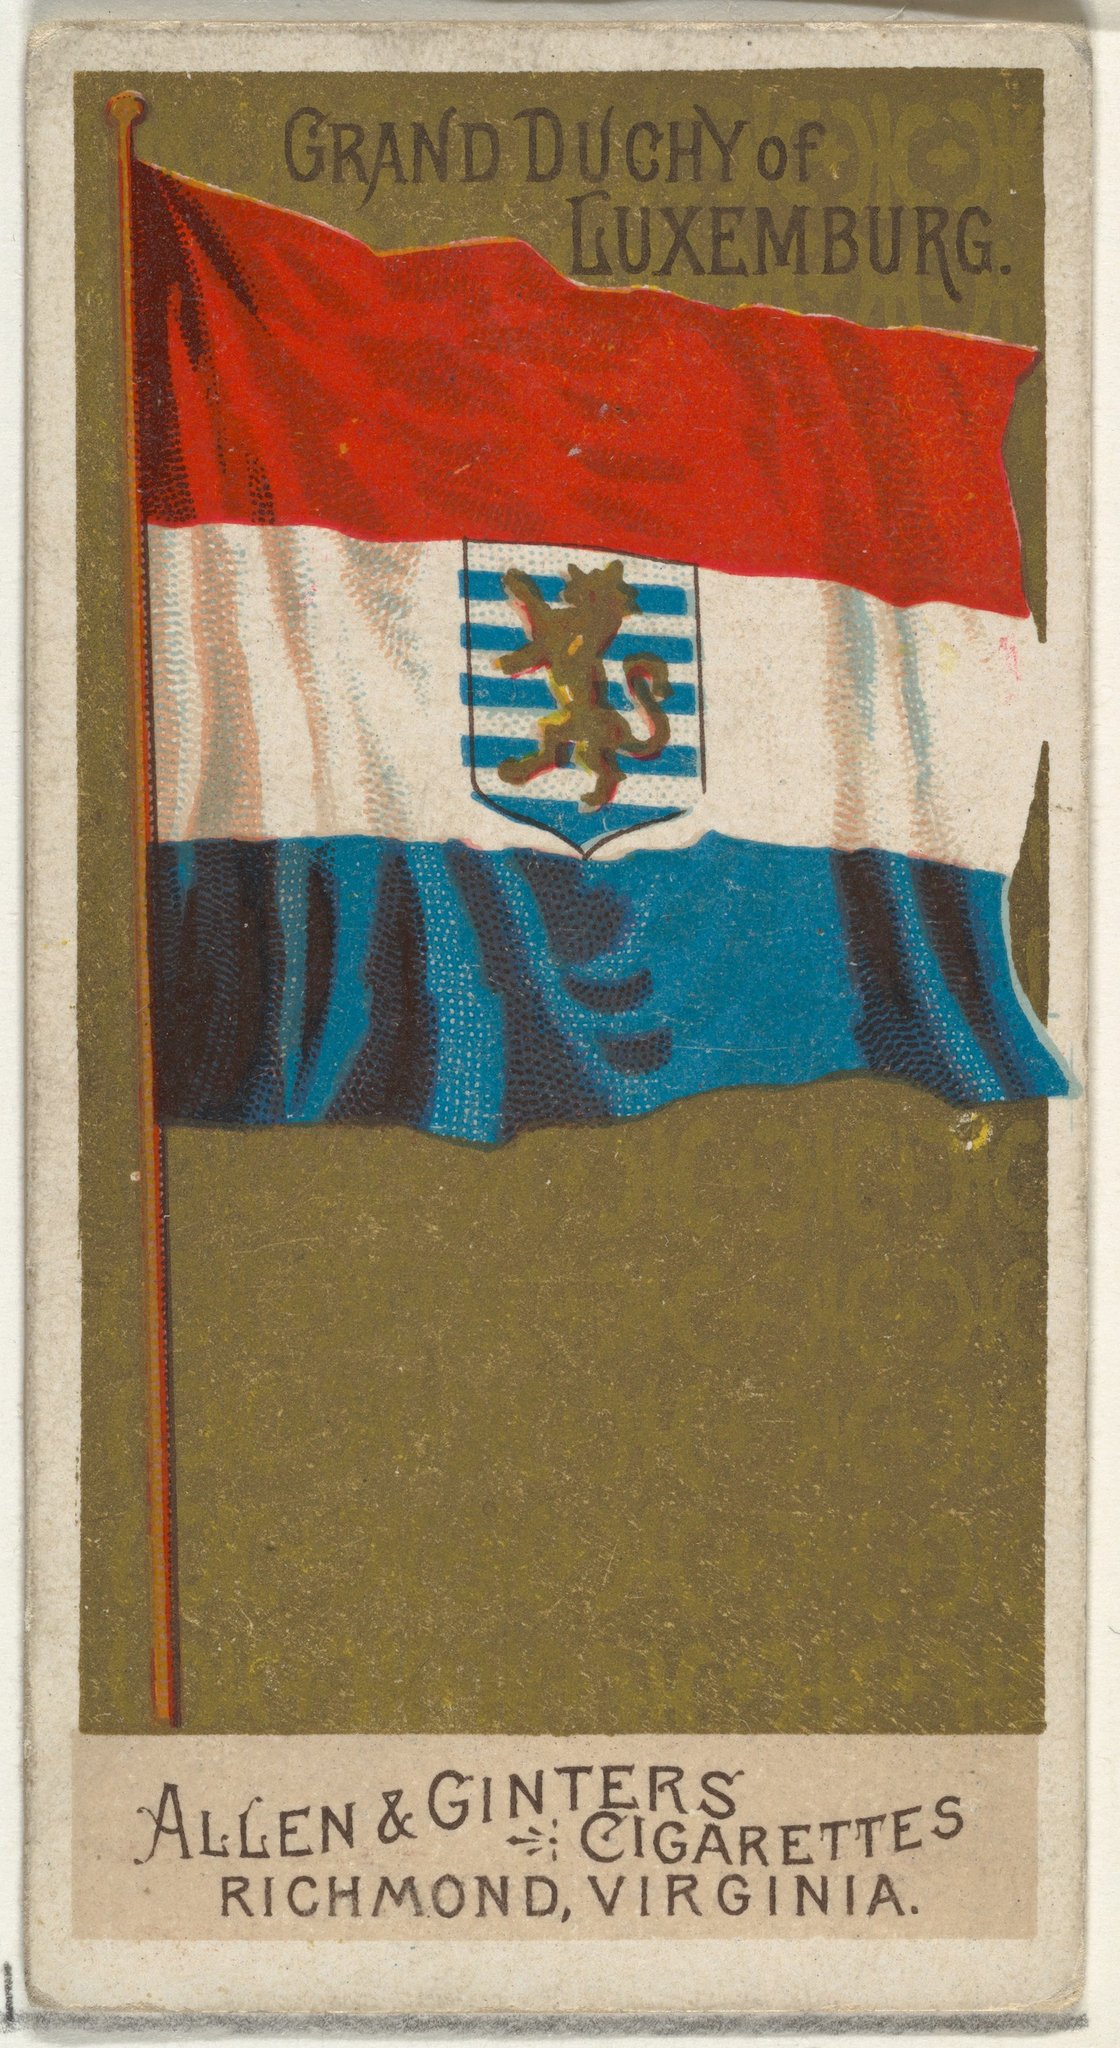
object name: print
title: Grand Duchy of Luxemburg, from Flags of All Nations, Series 2 (N10) for Allen & Ginter Cigarettes Brands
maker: allen & ginter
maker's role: publisher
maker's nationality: american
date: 1890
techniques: color lithograph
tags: coat of arms,flags